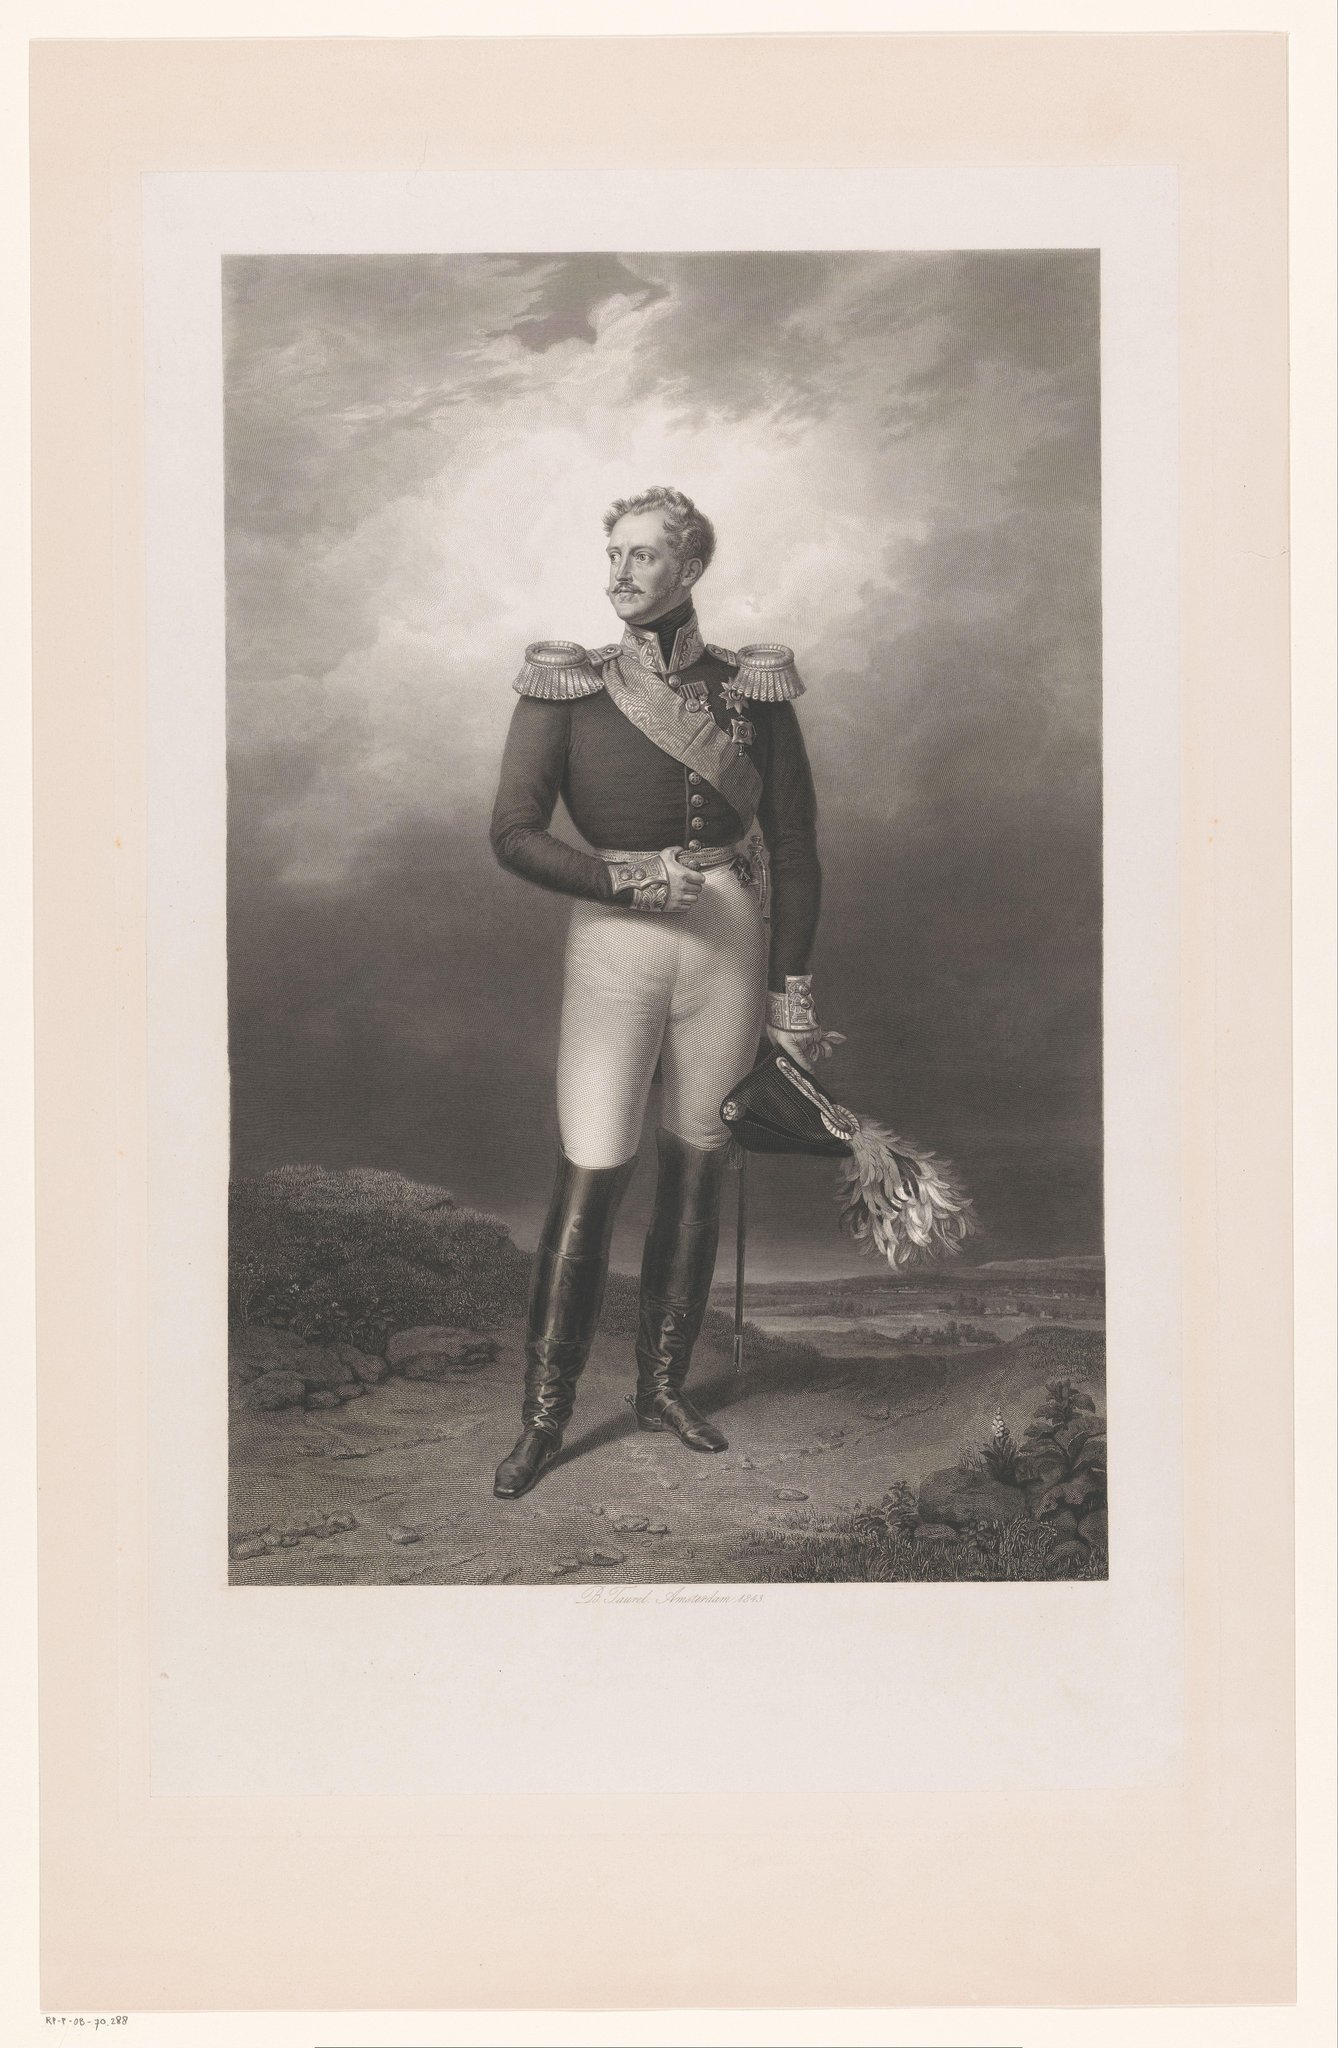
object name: print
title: Portret van Nicolaas I Pavlovitsj, tsaar van Rusland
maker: benoit taurel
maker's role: draughtsman, print maker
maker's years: 1794-1859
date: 1843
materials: paper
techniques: engraving, etching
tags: tsarskoje selo, nicolaas i pavlovitsj (tsaar van rusland)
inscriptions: collector's mark: Lugt 2228, collector's mark: Lugt 12